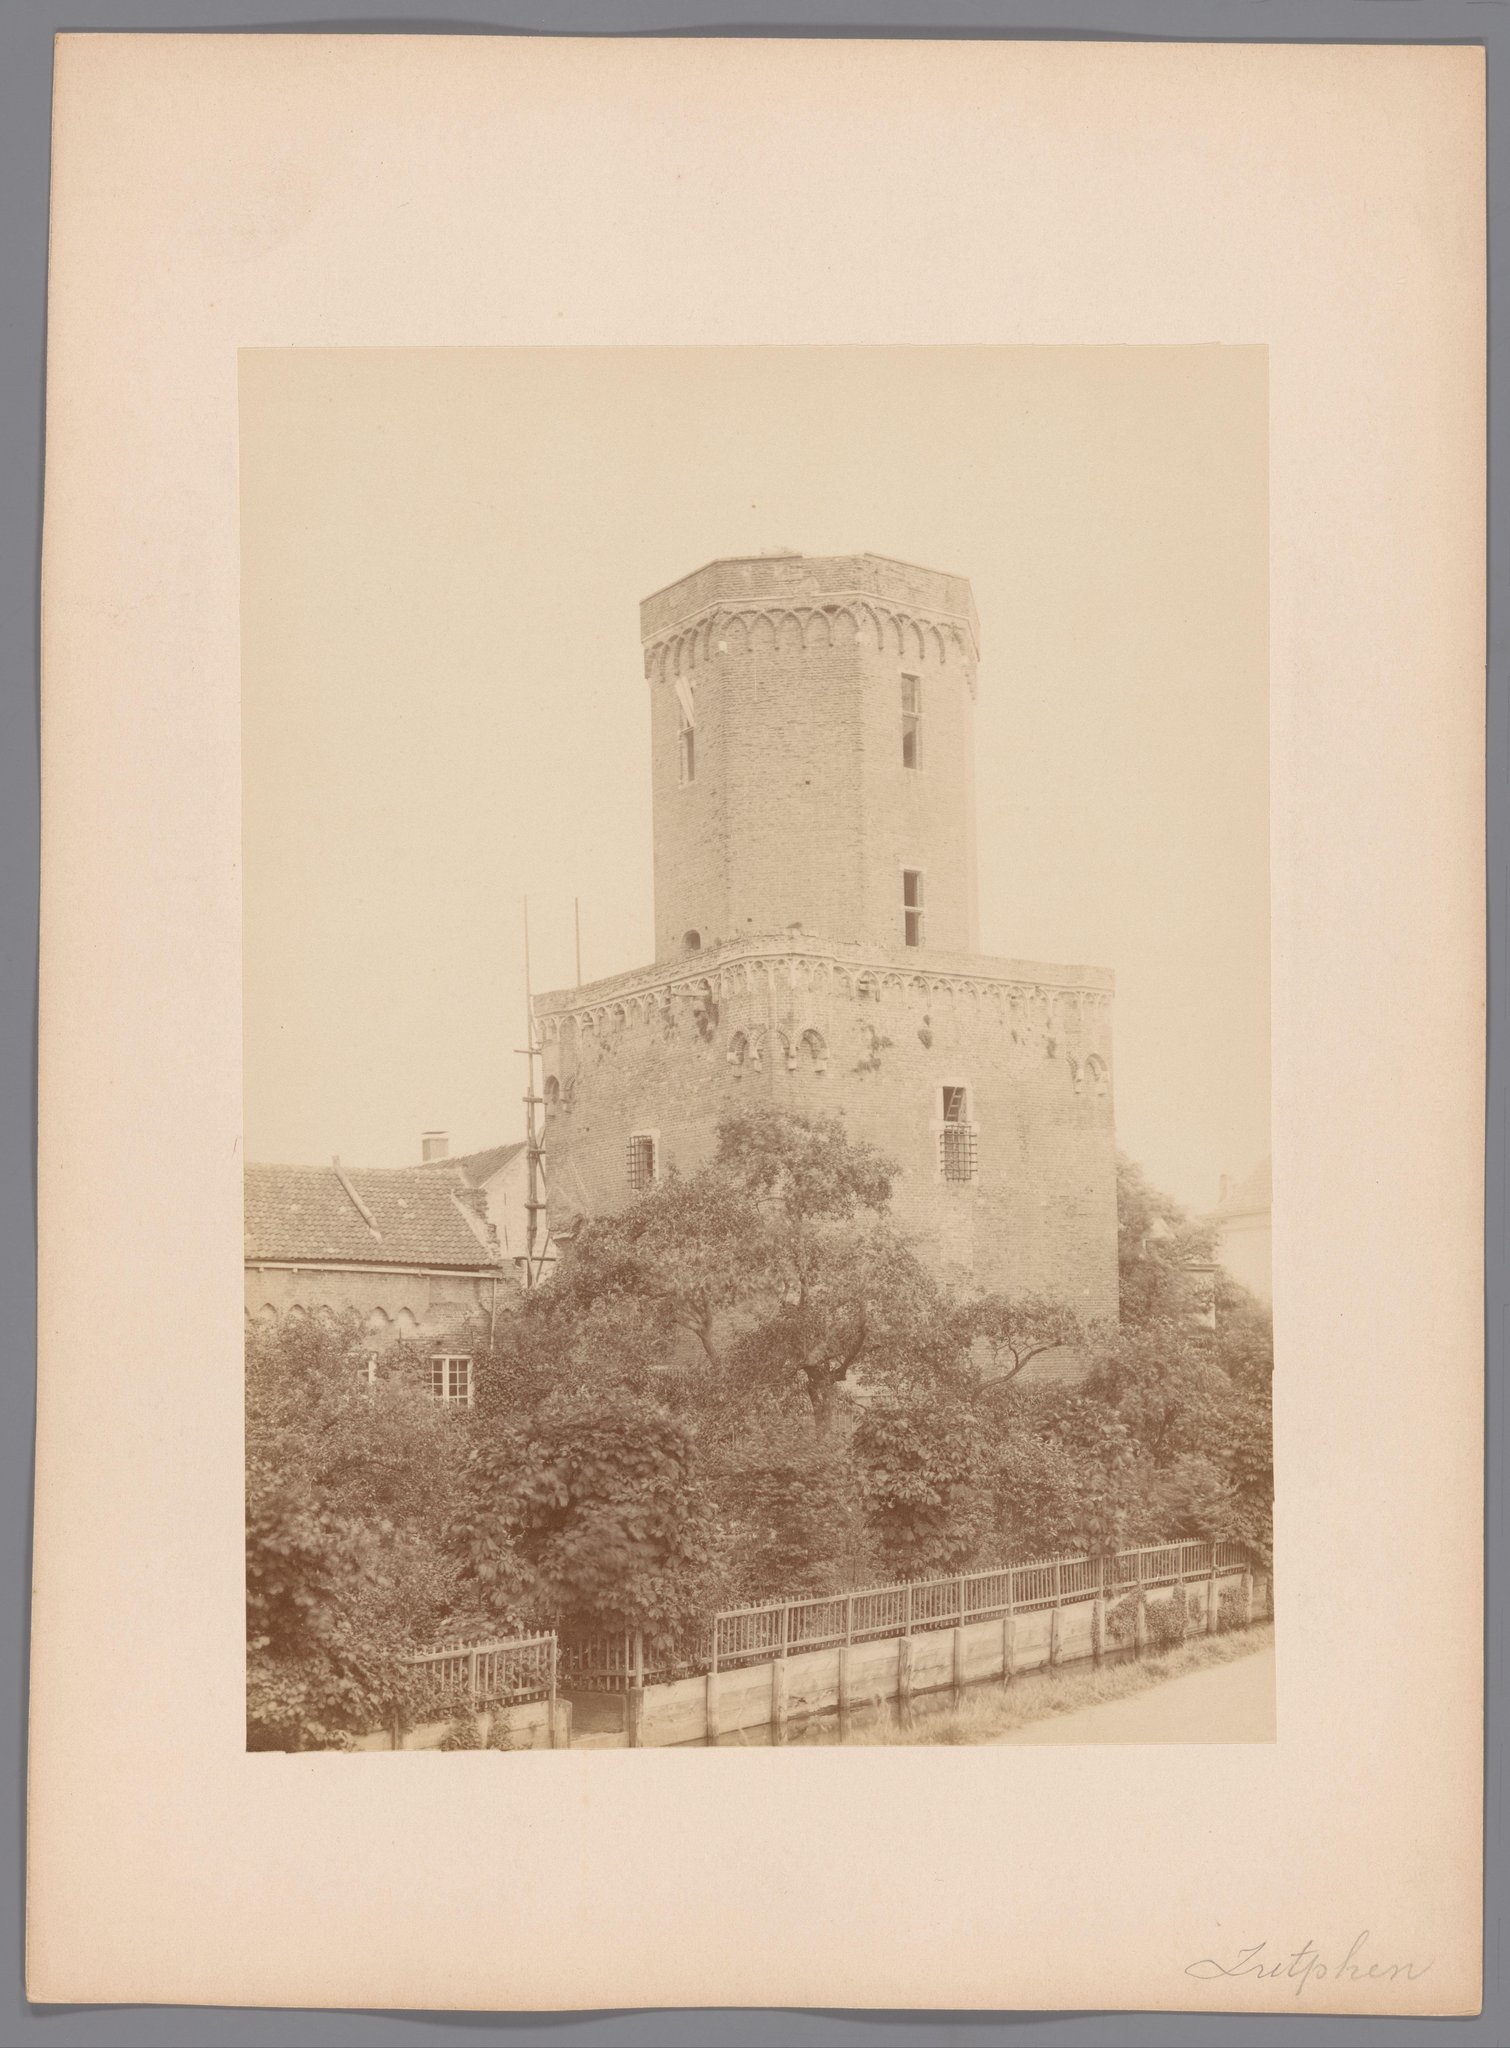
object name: photograph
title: Gezicht op de Drogenapstoren te Zutphen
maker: anoniem (monumentenzorg)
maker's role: fotograaf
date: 1890-1910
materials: cardboard, photographic support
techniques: albumen print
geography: zutphen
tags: city-gate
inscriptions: annotation: ‘Zutphen’, annotation: ‘Drogenapstoren te Zutphen gezien van buiten’